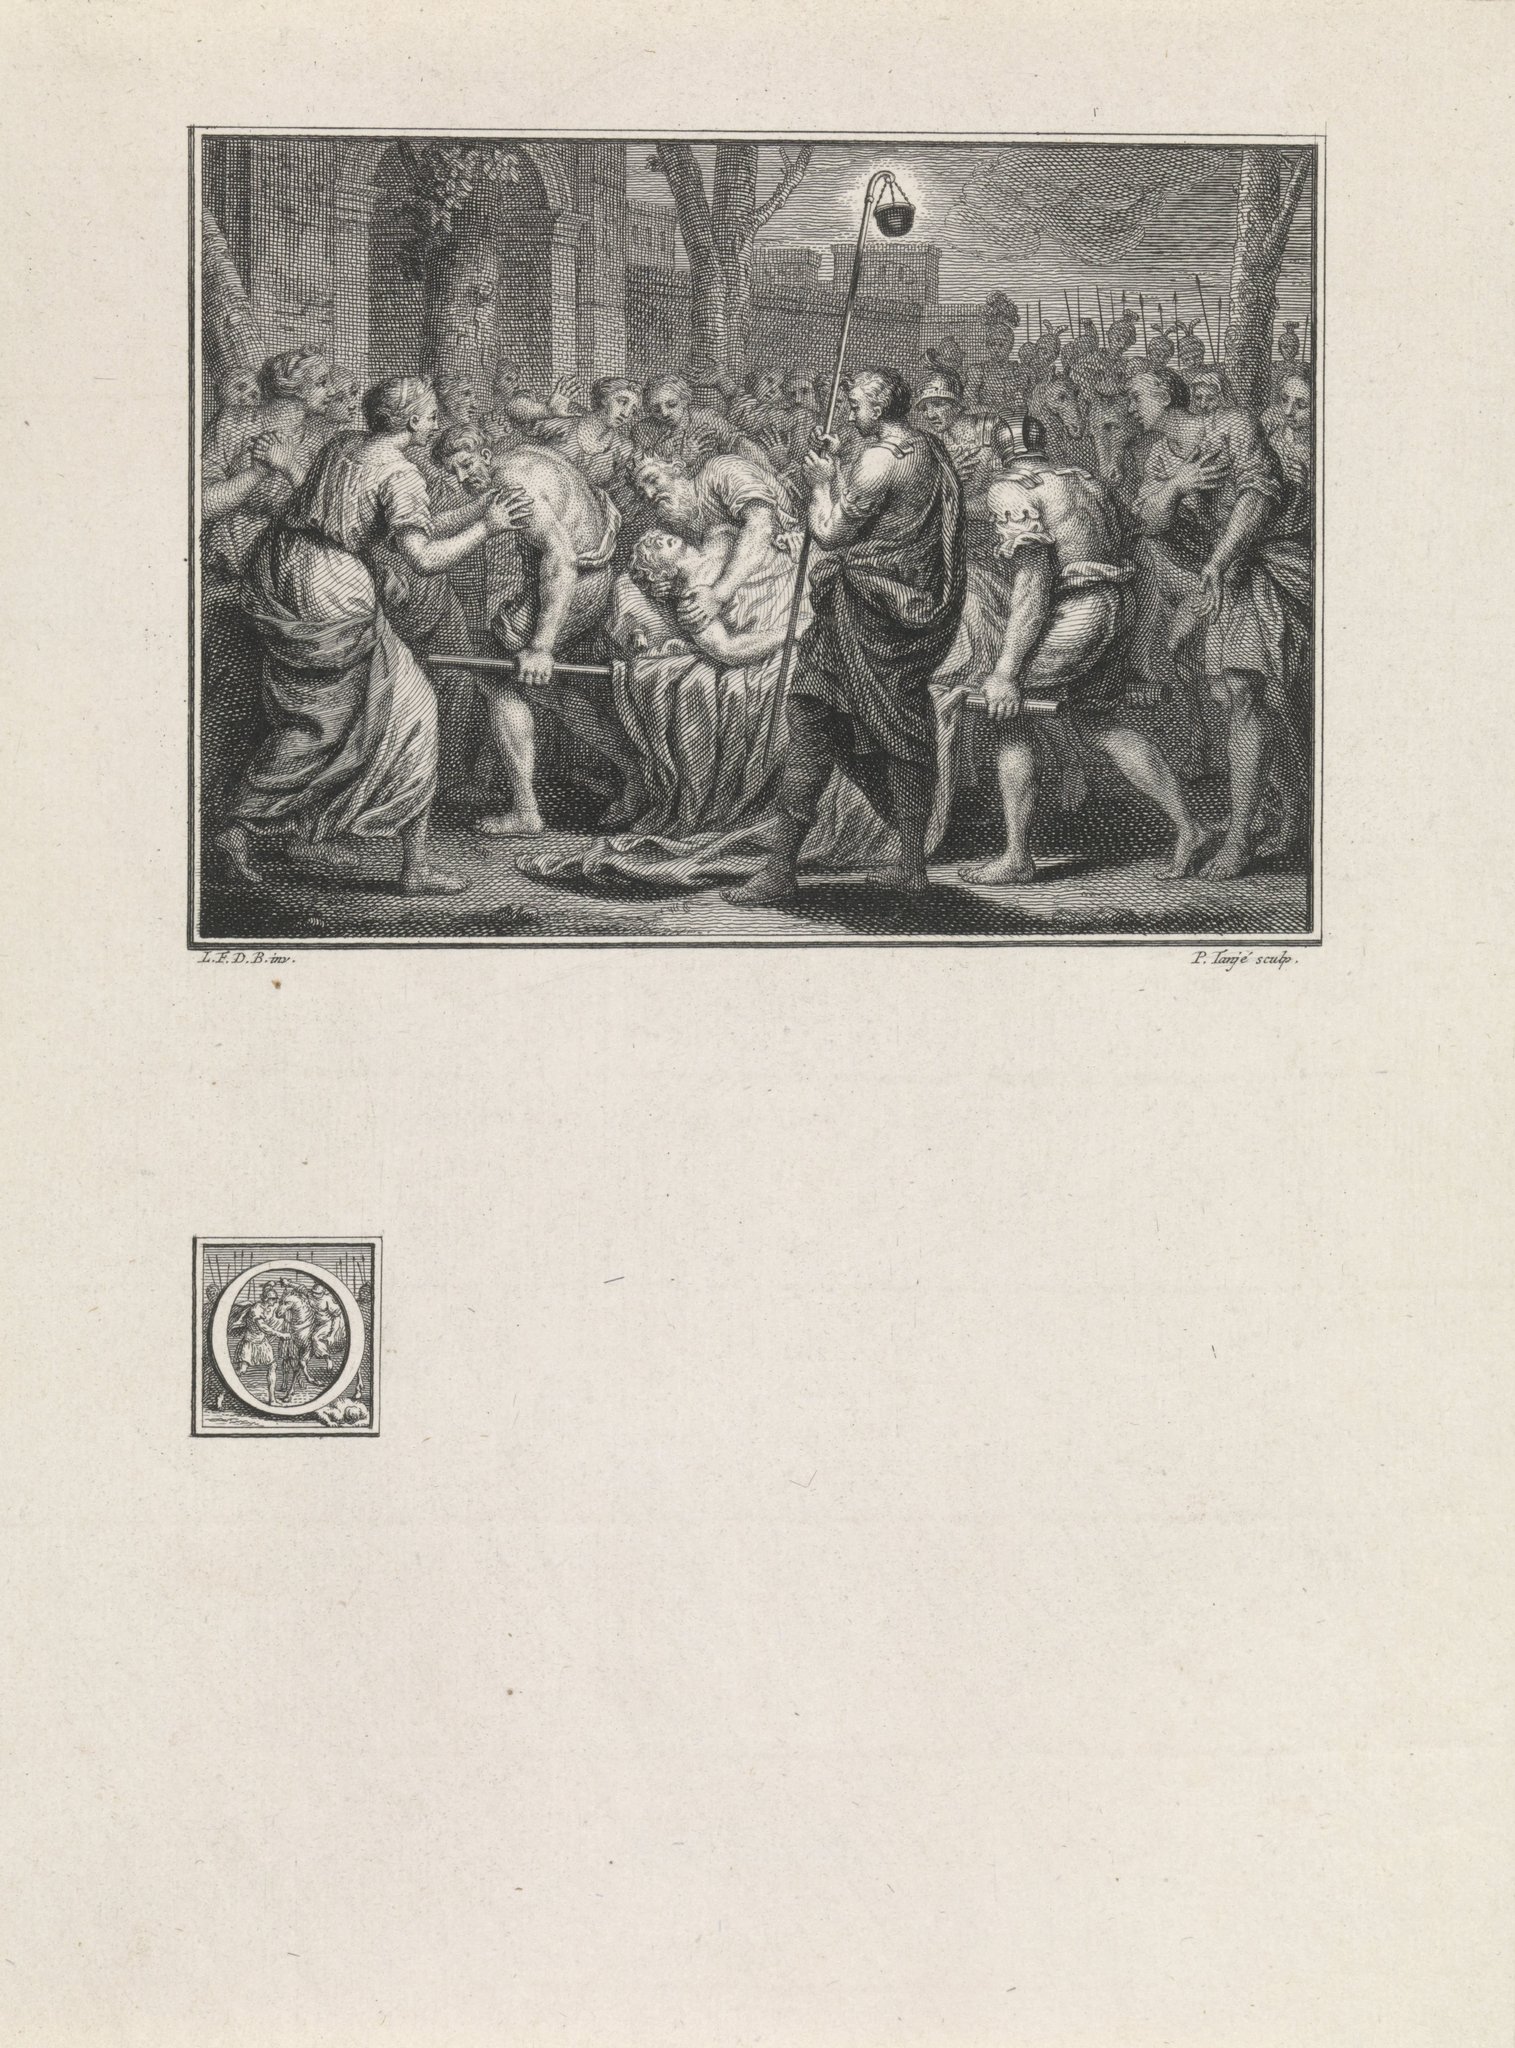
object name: book illustration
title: Scène uit de Aeneis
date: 1746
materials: paper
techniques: engraving, etching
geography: amsterdam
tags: the story of aeneas' wanderings to italy (virgil, aeneid), mourning customs, the corpse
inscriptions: collector's mark: Lugt 240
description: Illustratie en initiaal O bij de Aeneis van Vergilius. Het lichaam van een man wordt op een draagbaar gedragen, terwijl het volk en een koning hem bewenen.